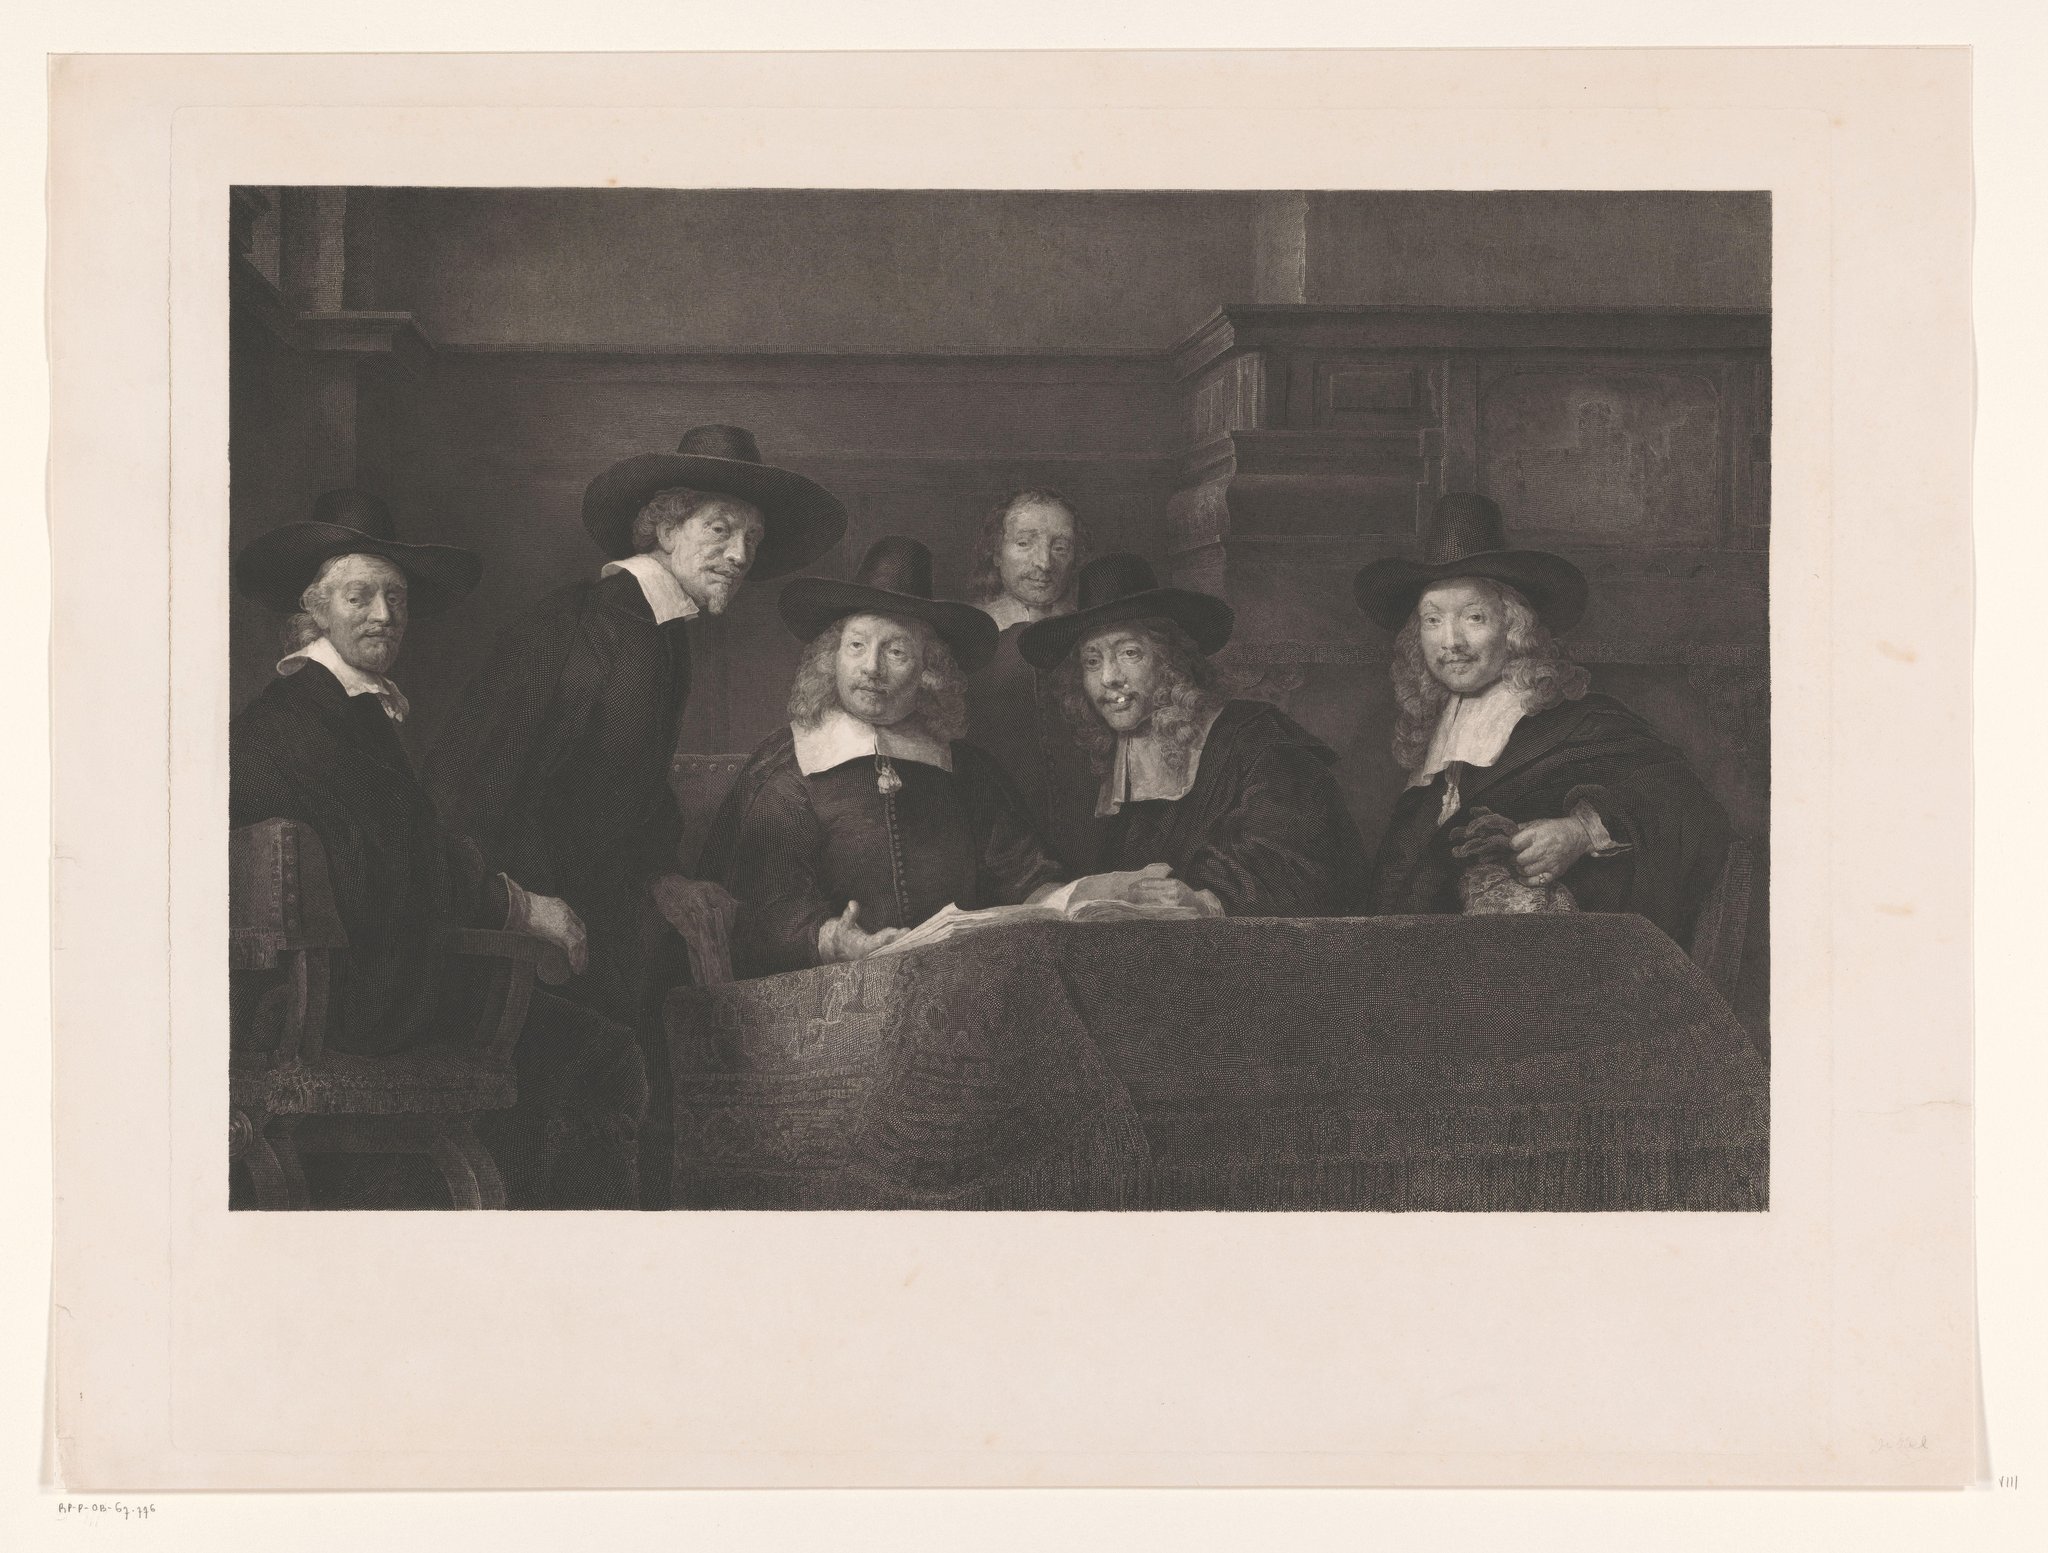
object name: print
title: De waardijns van het Amsterdamse lakenbereidersgilde, bekend als ‘De Staalmeesters’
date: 1846-1900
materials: paper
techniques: engraving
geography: netherlands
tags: control of quality, amsterdam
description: De Staalmeesters: het college van staalmeesters of waardijns van het Amsterdamse lakenbereidersgilde, bijeen rond een tafel waarop een Perzisch kleed ligt. Op tafel het opengeslagen stalenboek. Voorgesteld zijn van links naar rechts: Jochem de Neve (1629-81), Aernout van der Mye (ca. 1625-81), de knecht Frans Hendricksz Bel (1629-1701), Willem van Doeyenburg (ca. 1616-87), Volckert Jansz (1605/10-81), Jacob van Loon (1595-1674). Links boven de haard een schilderij met een brandend baken.